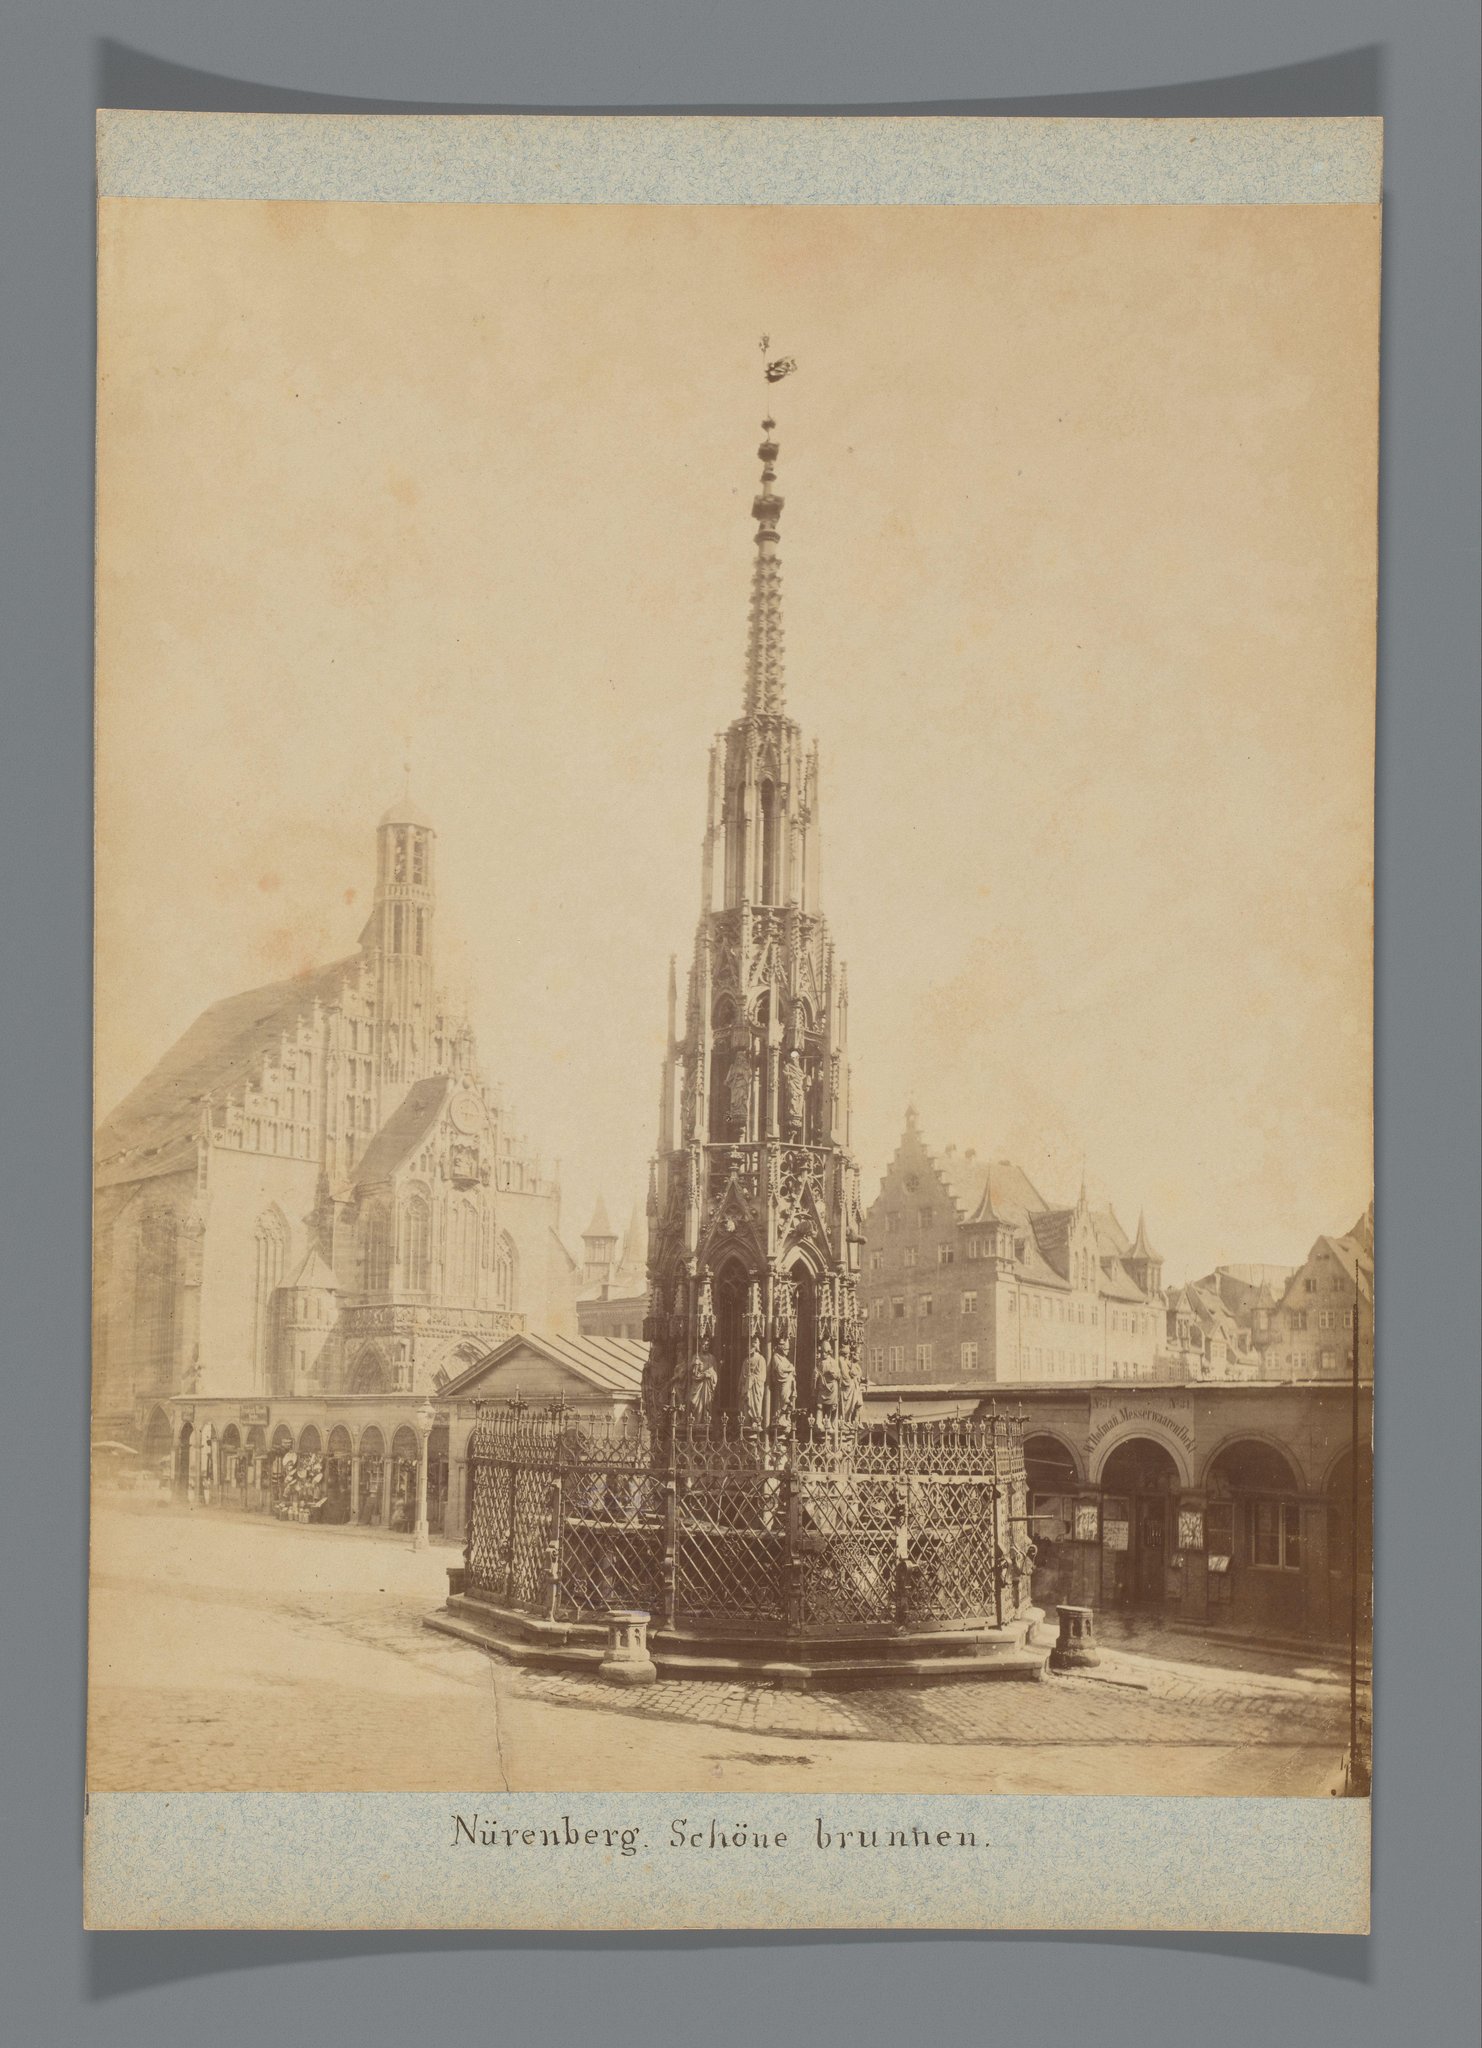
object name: photograph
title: Neurenberg, Schöne brunnen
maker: Anonymous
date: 1850-1900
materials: cardboard, paper, photographic support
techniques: albumen print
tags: neurenberg